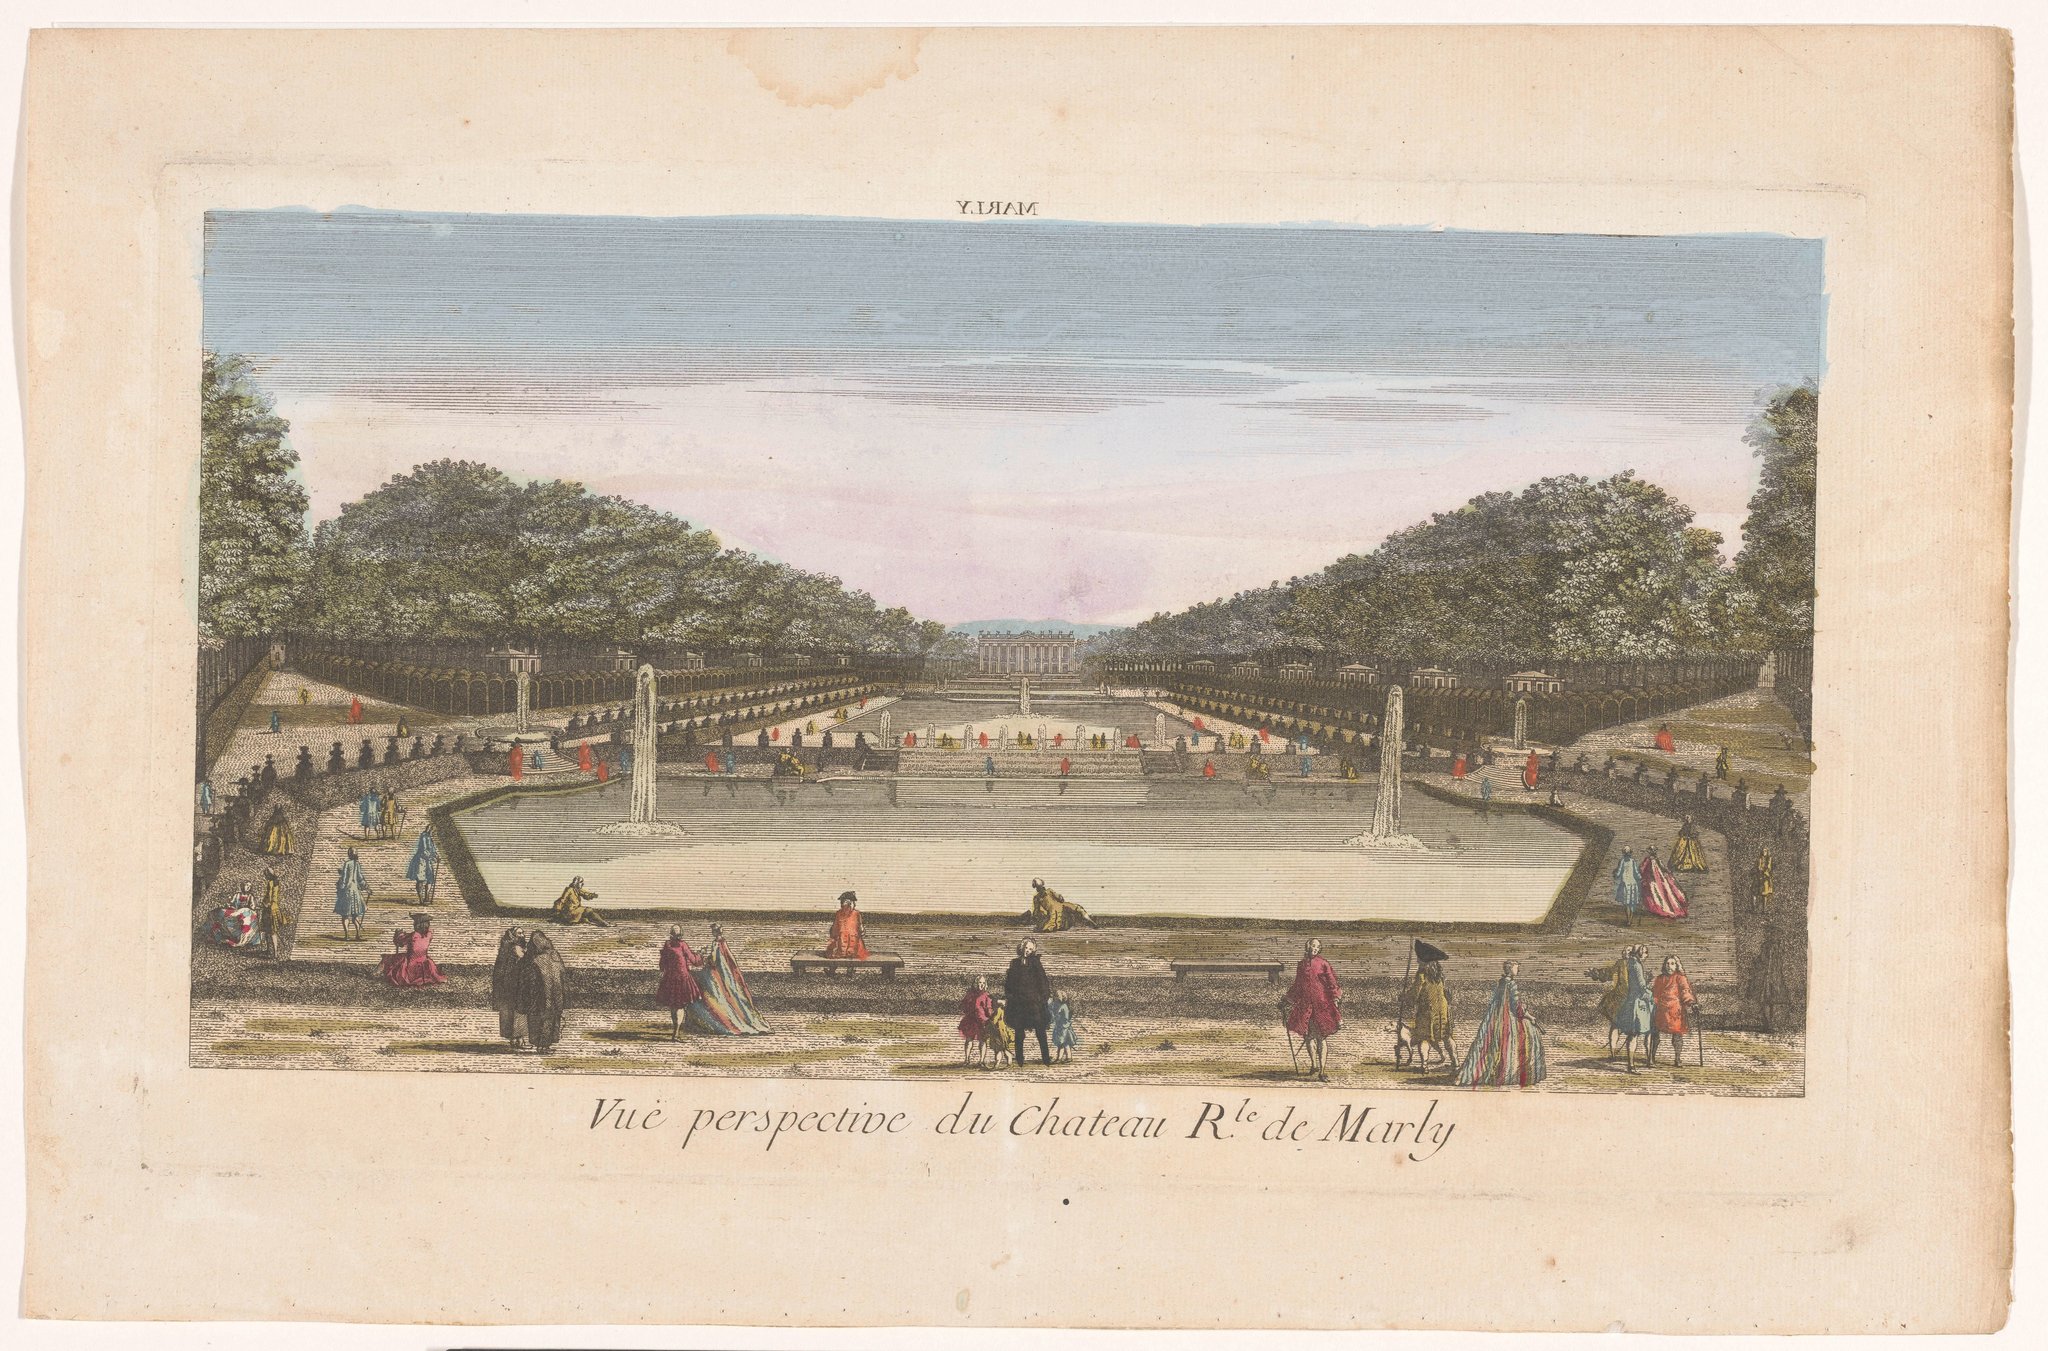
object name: print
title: Vuë perspective du Chateau Rle. de Marly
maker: Anonymous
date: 1700-1799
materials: paper, watercolor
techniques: brush, etching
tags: civic architecture; edifices; dwellings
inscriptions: watermark, collector's mark: Lugt 2166